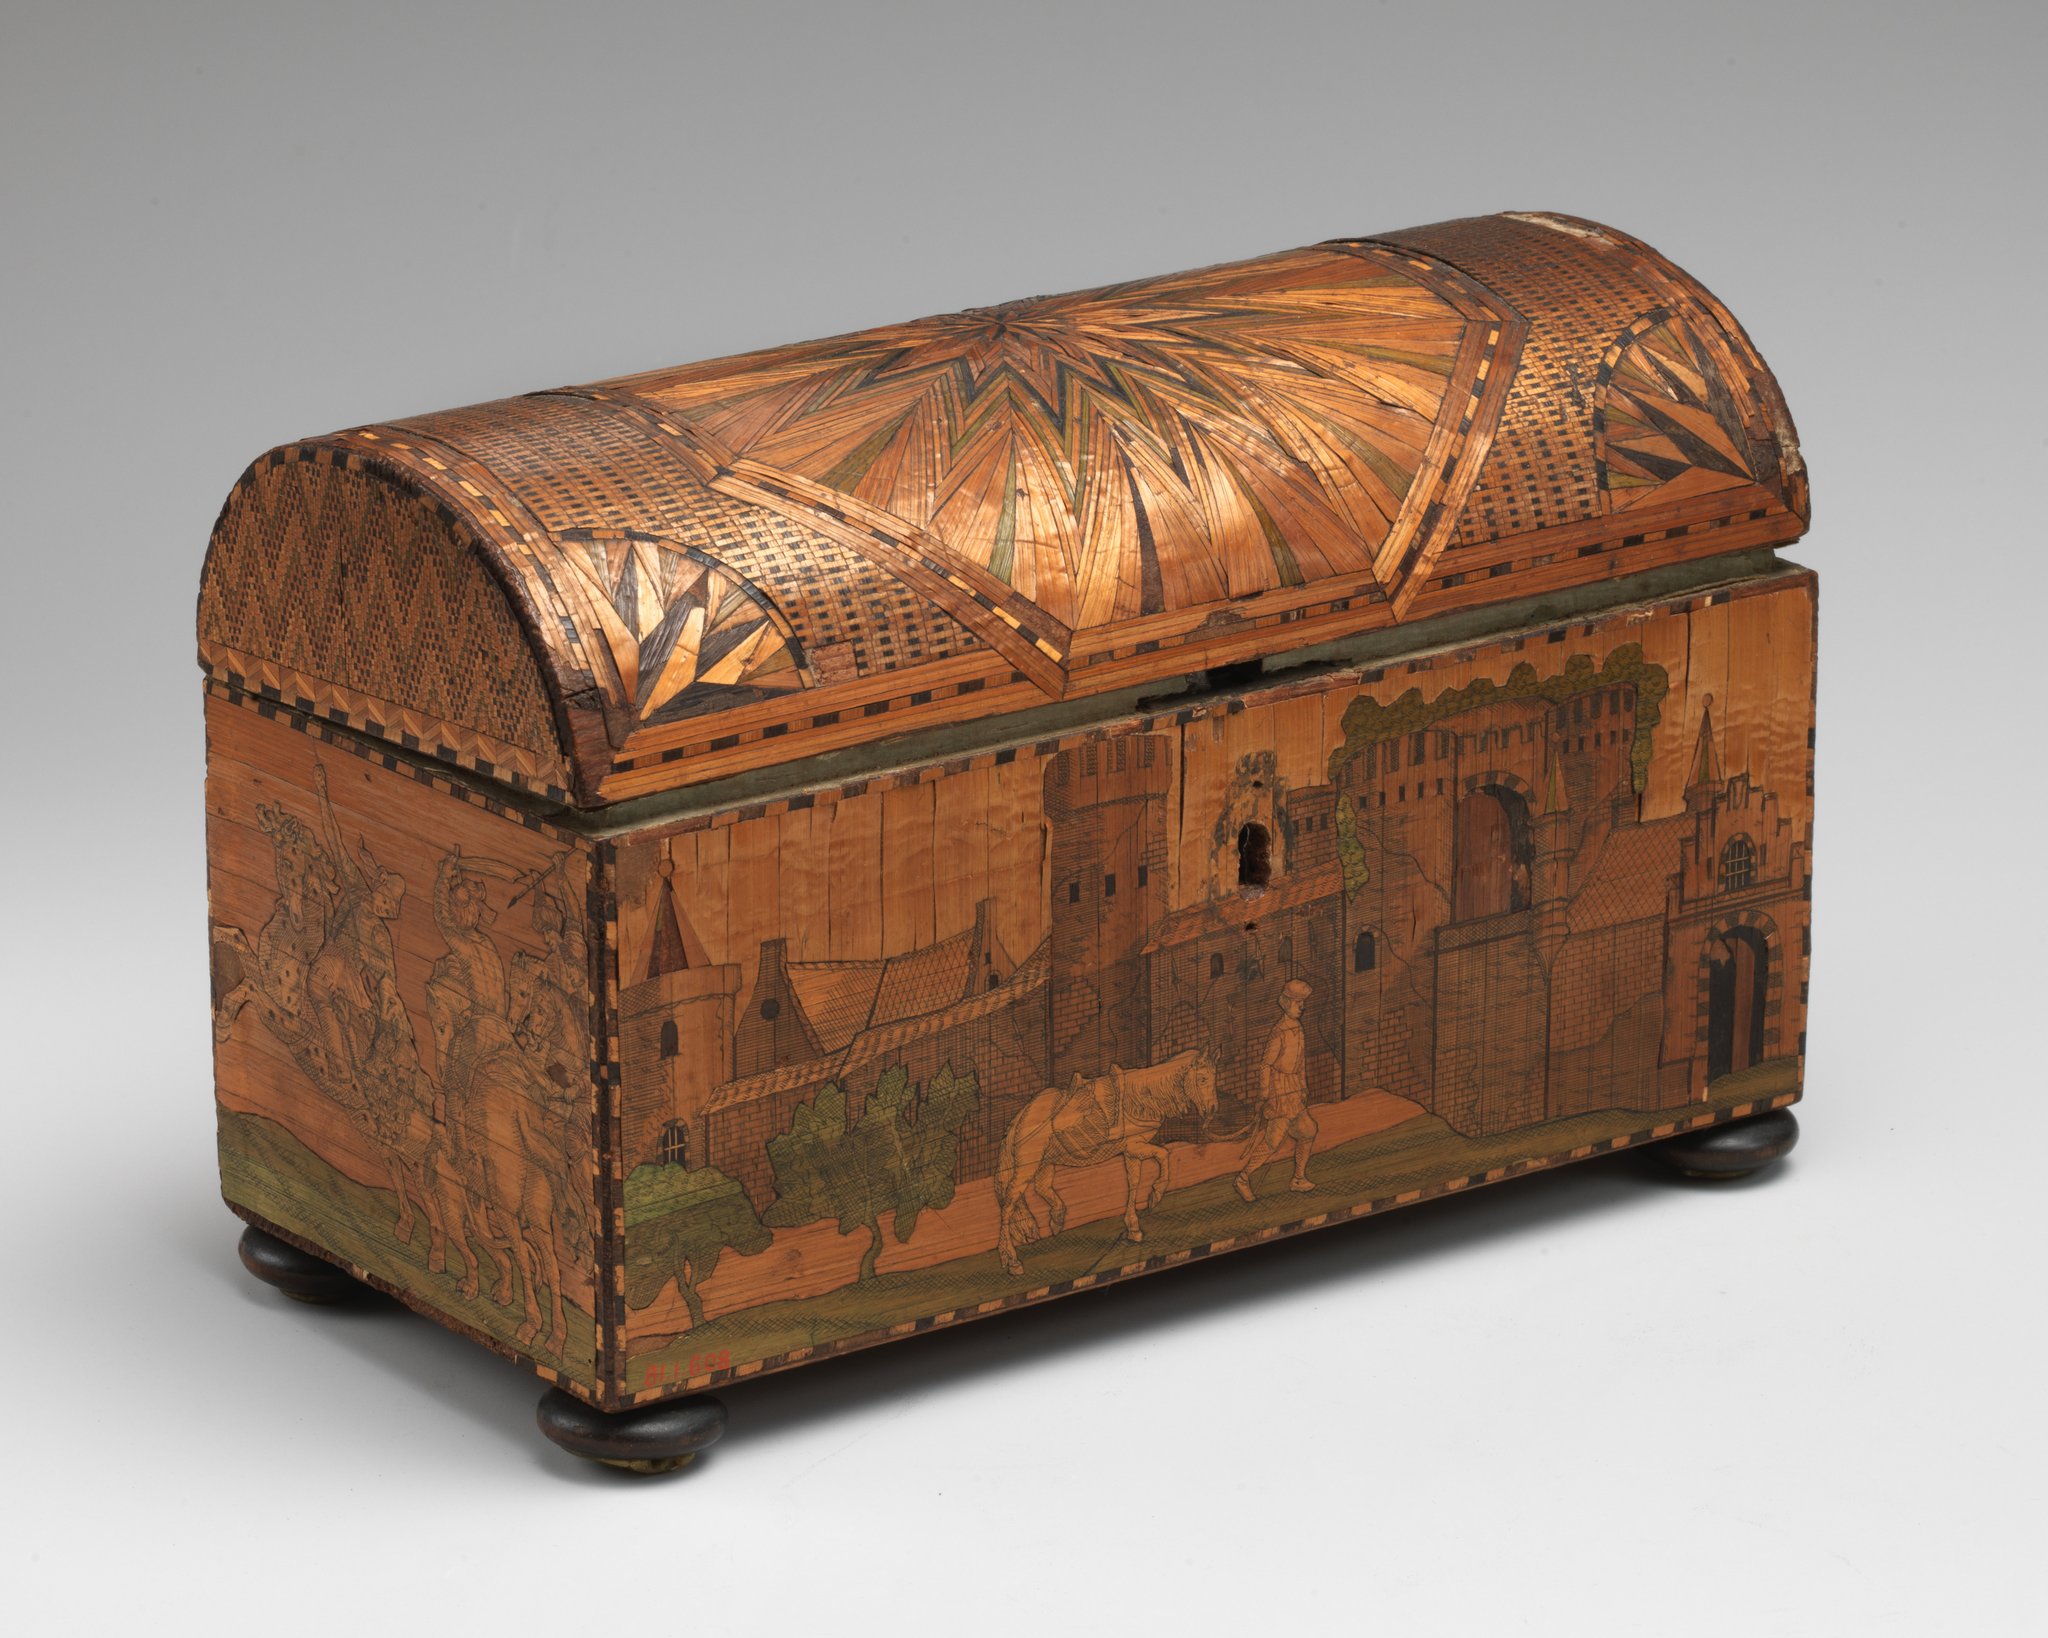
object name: casket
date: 1701-1800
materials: silk, fiber, wood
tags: castles,men,hunting,horses